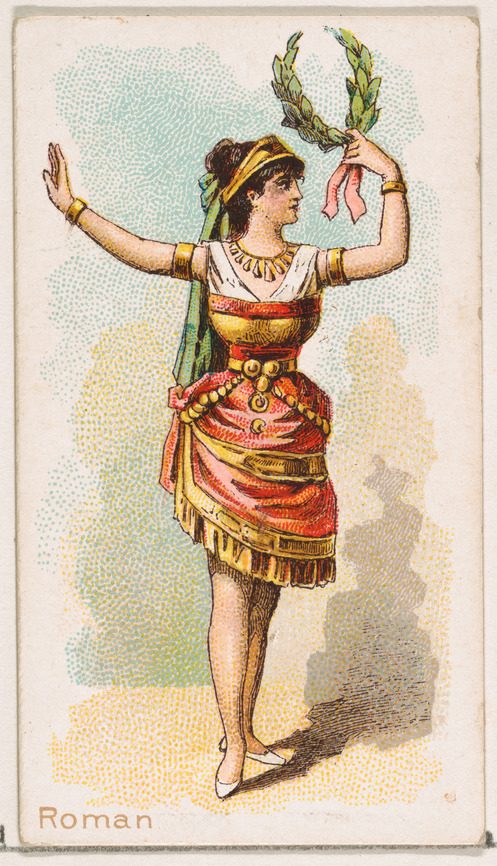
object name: print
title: Roman Dancer, from the Dancing Women series (N186) issued by Wm. S. Kimball & Co.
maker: william s. kimball & company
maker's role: publisher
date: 1889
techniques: color lithograph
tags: women,dancers